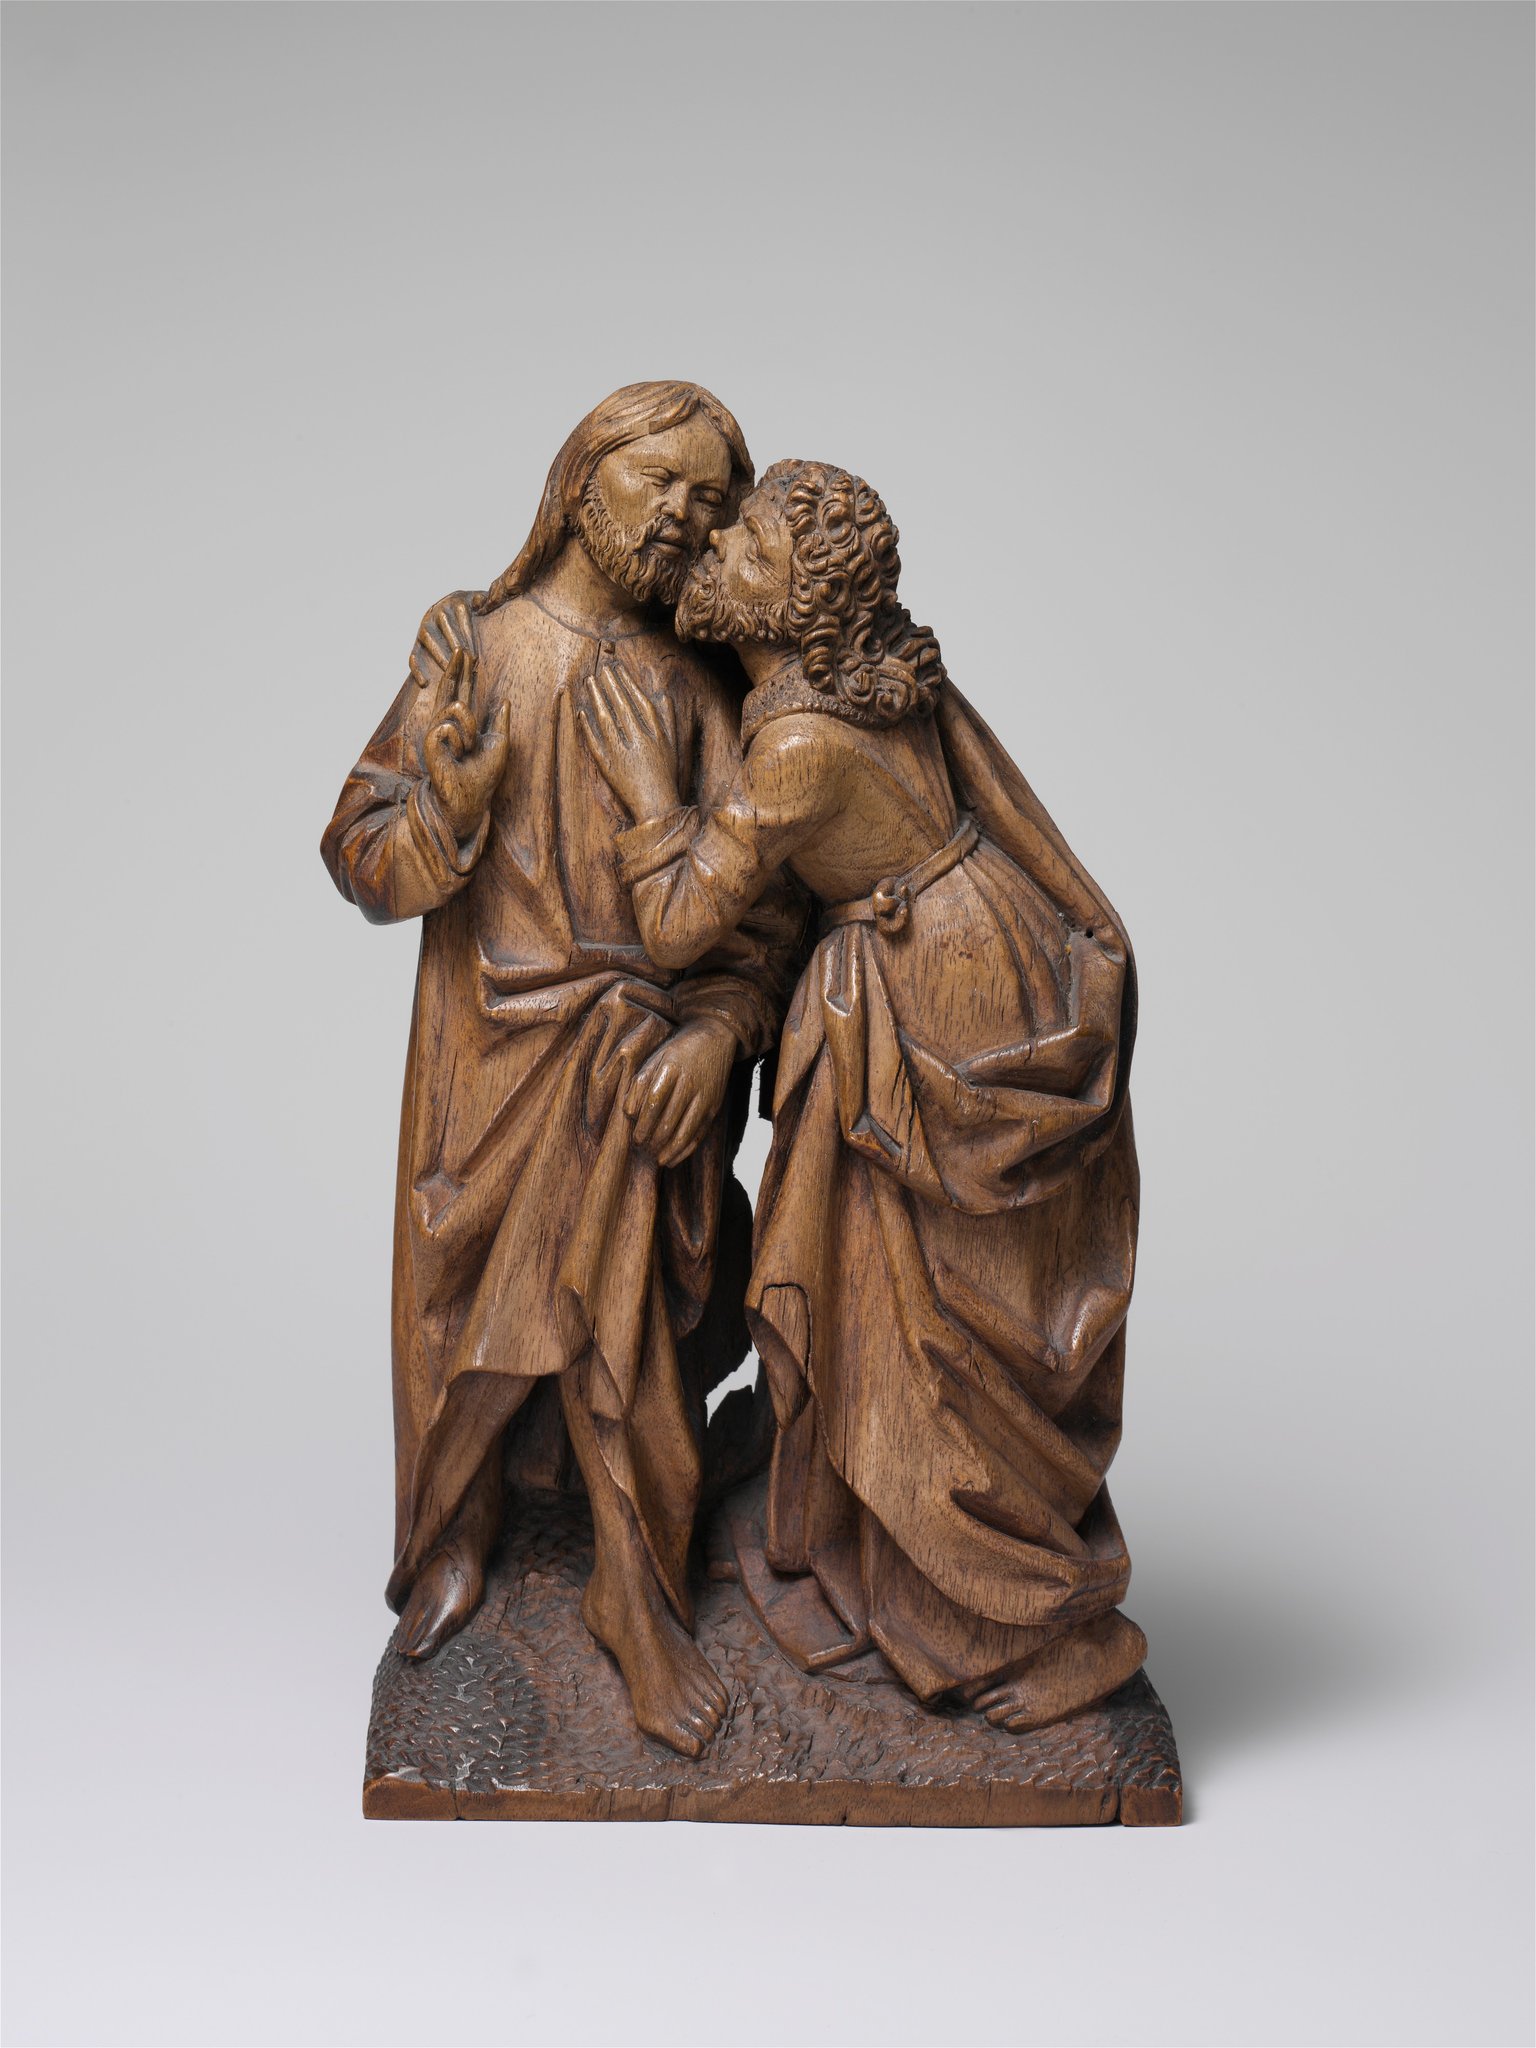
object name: relief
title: The Kiss of Judas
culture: german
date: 1501-1600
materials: wood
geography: germany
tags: jesus